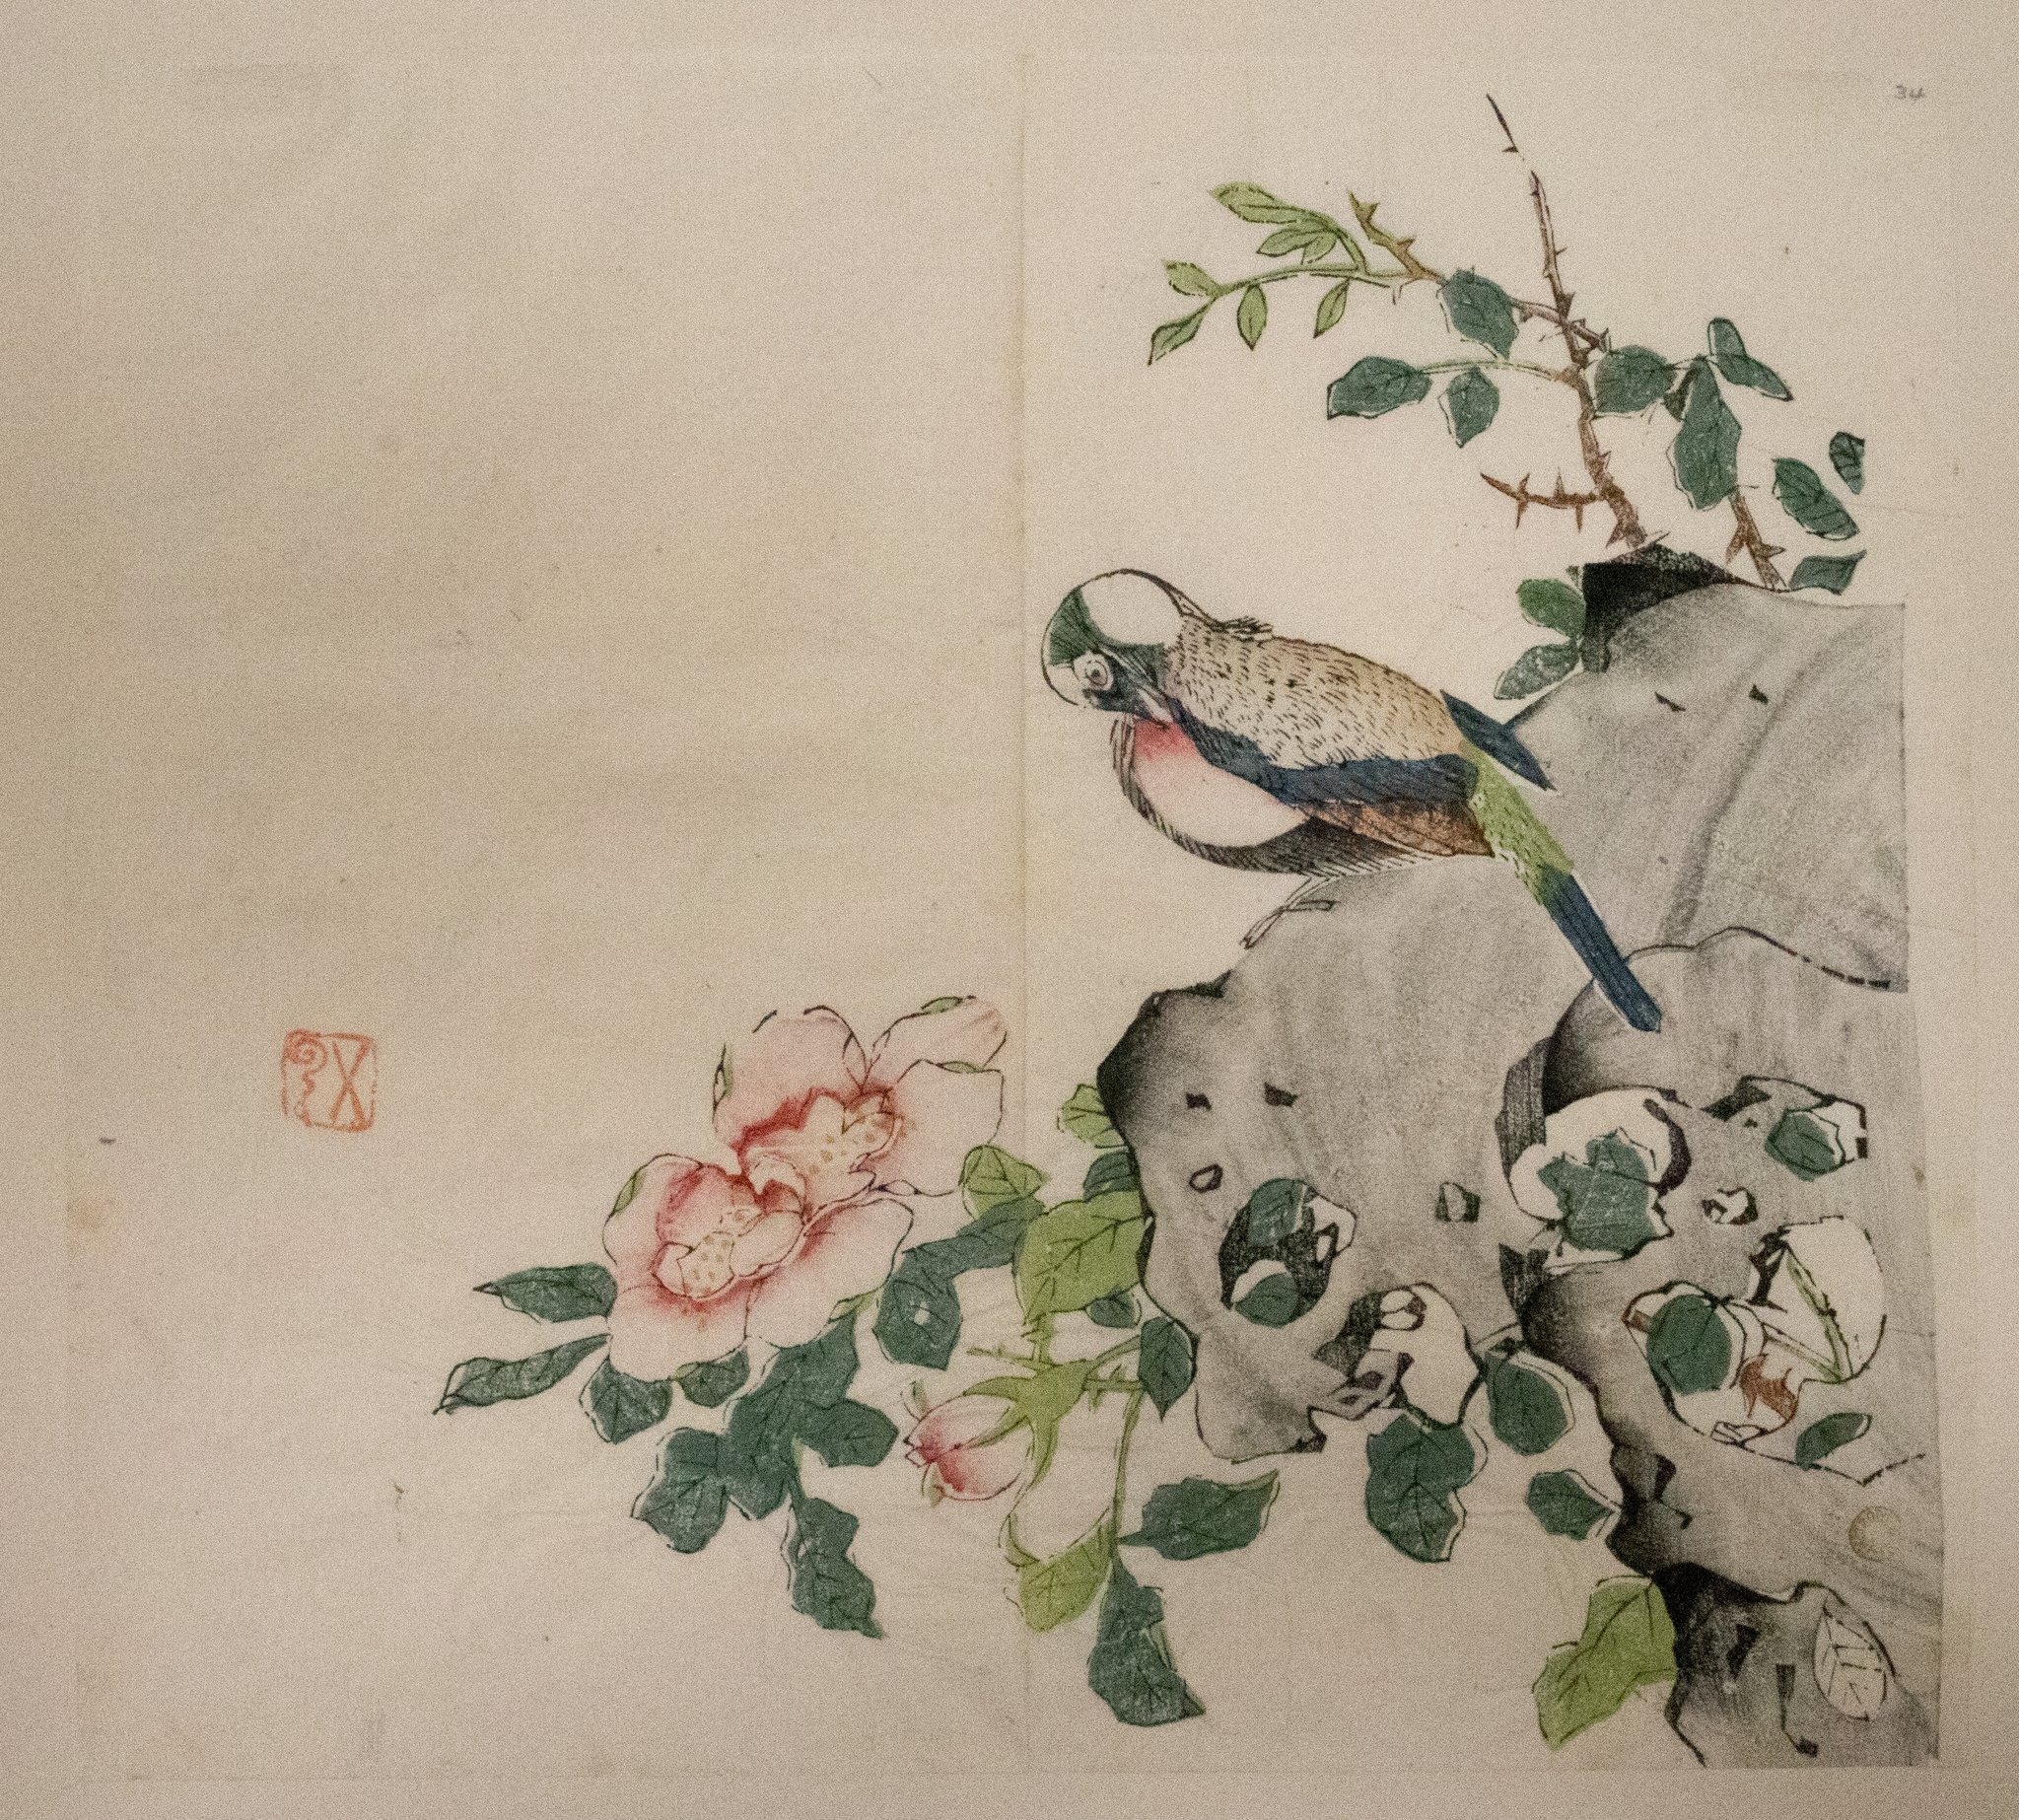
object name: print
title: Page from Shi Zhu Zhai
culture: chinese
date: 1736-1795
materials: ink, paper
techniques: polychrome, woodblock print